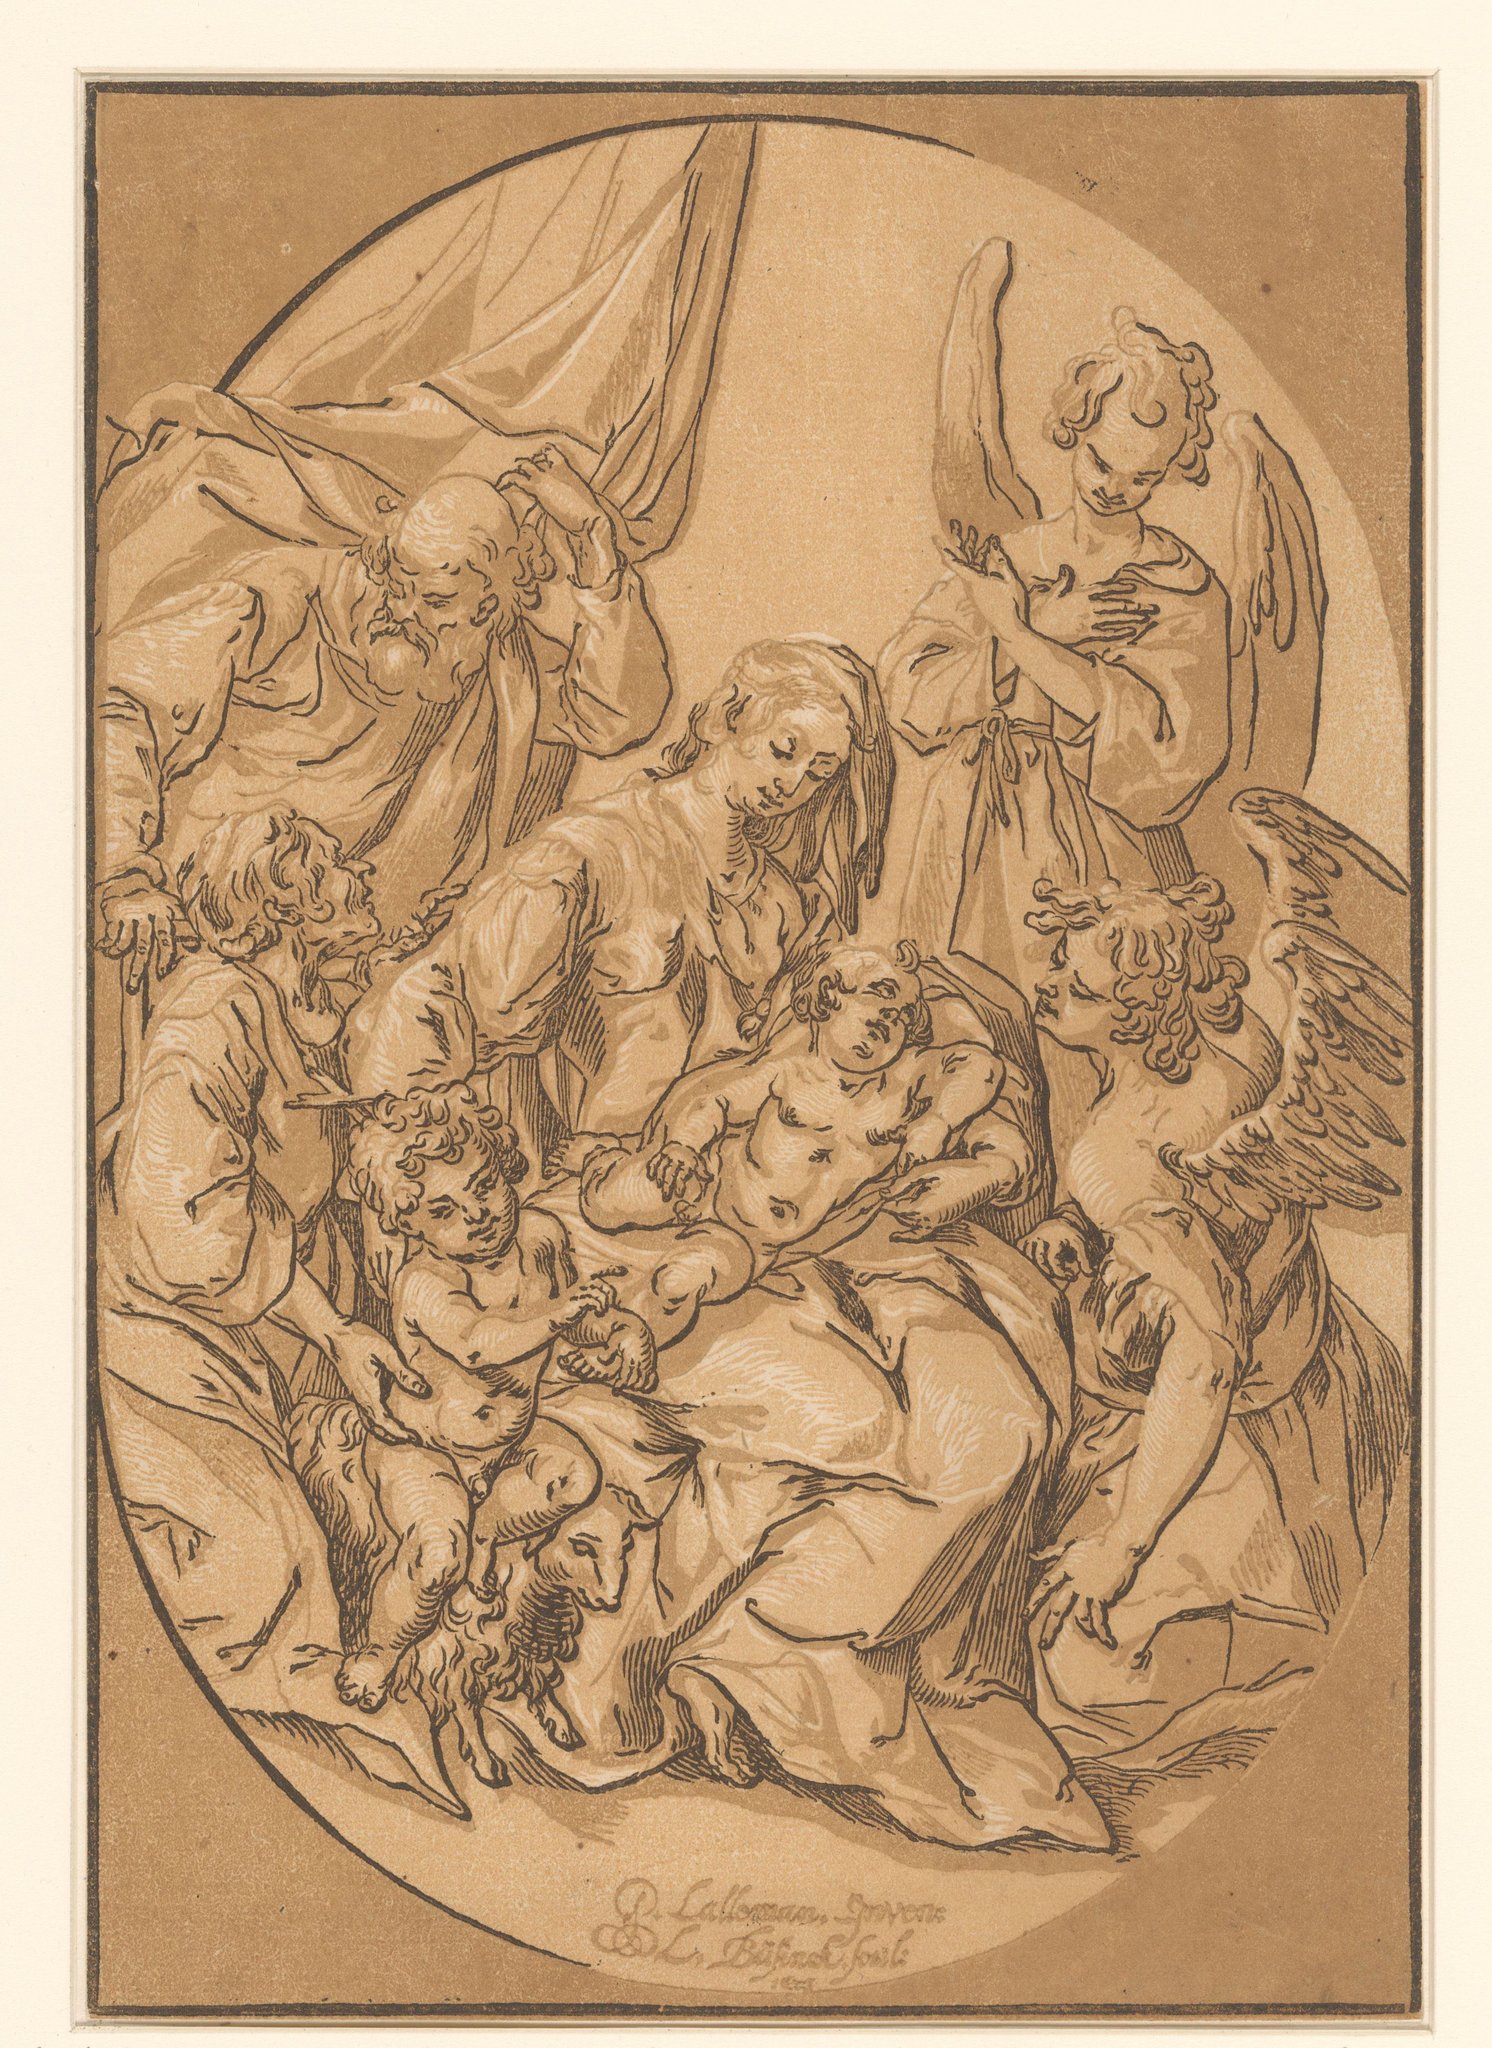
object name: print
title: Heilige Familie met Johannes de Doper, Elisabet en twee engelen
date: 1623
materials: paper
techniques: woodcut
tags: holy family with john the baptist, elisabeth present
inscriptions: collector's mark: ‘CD’